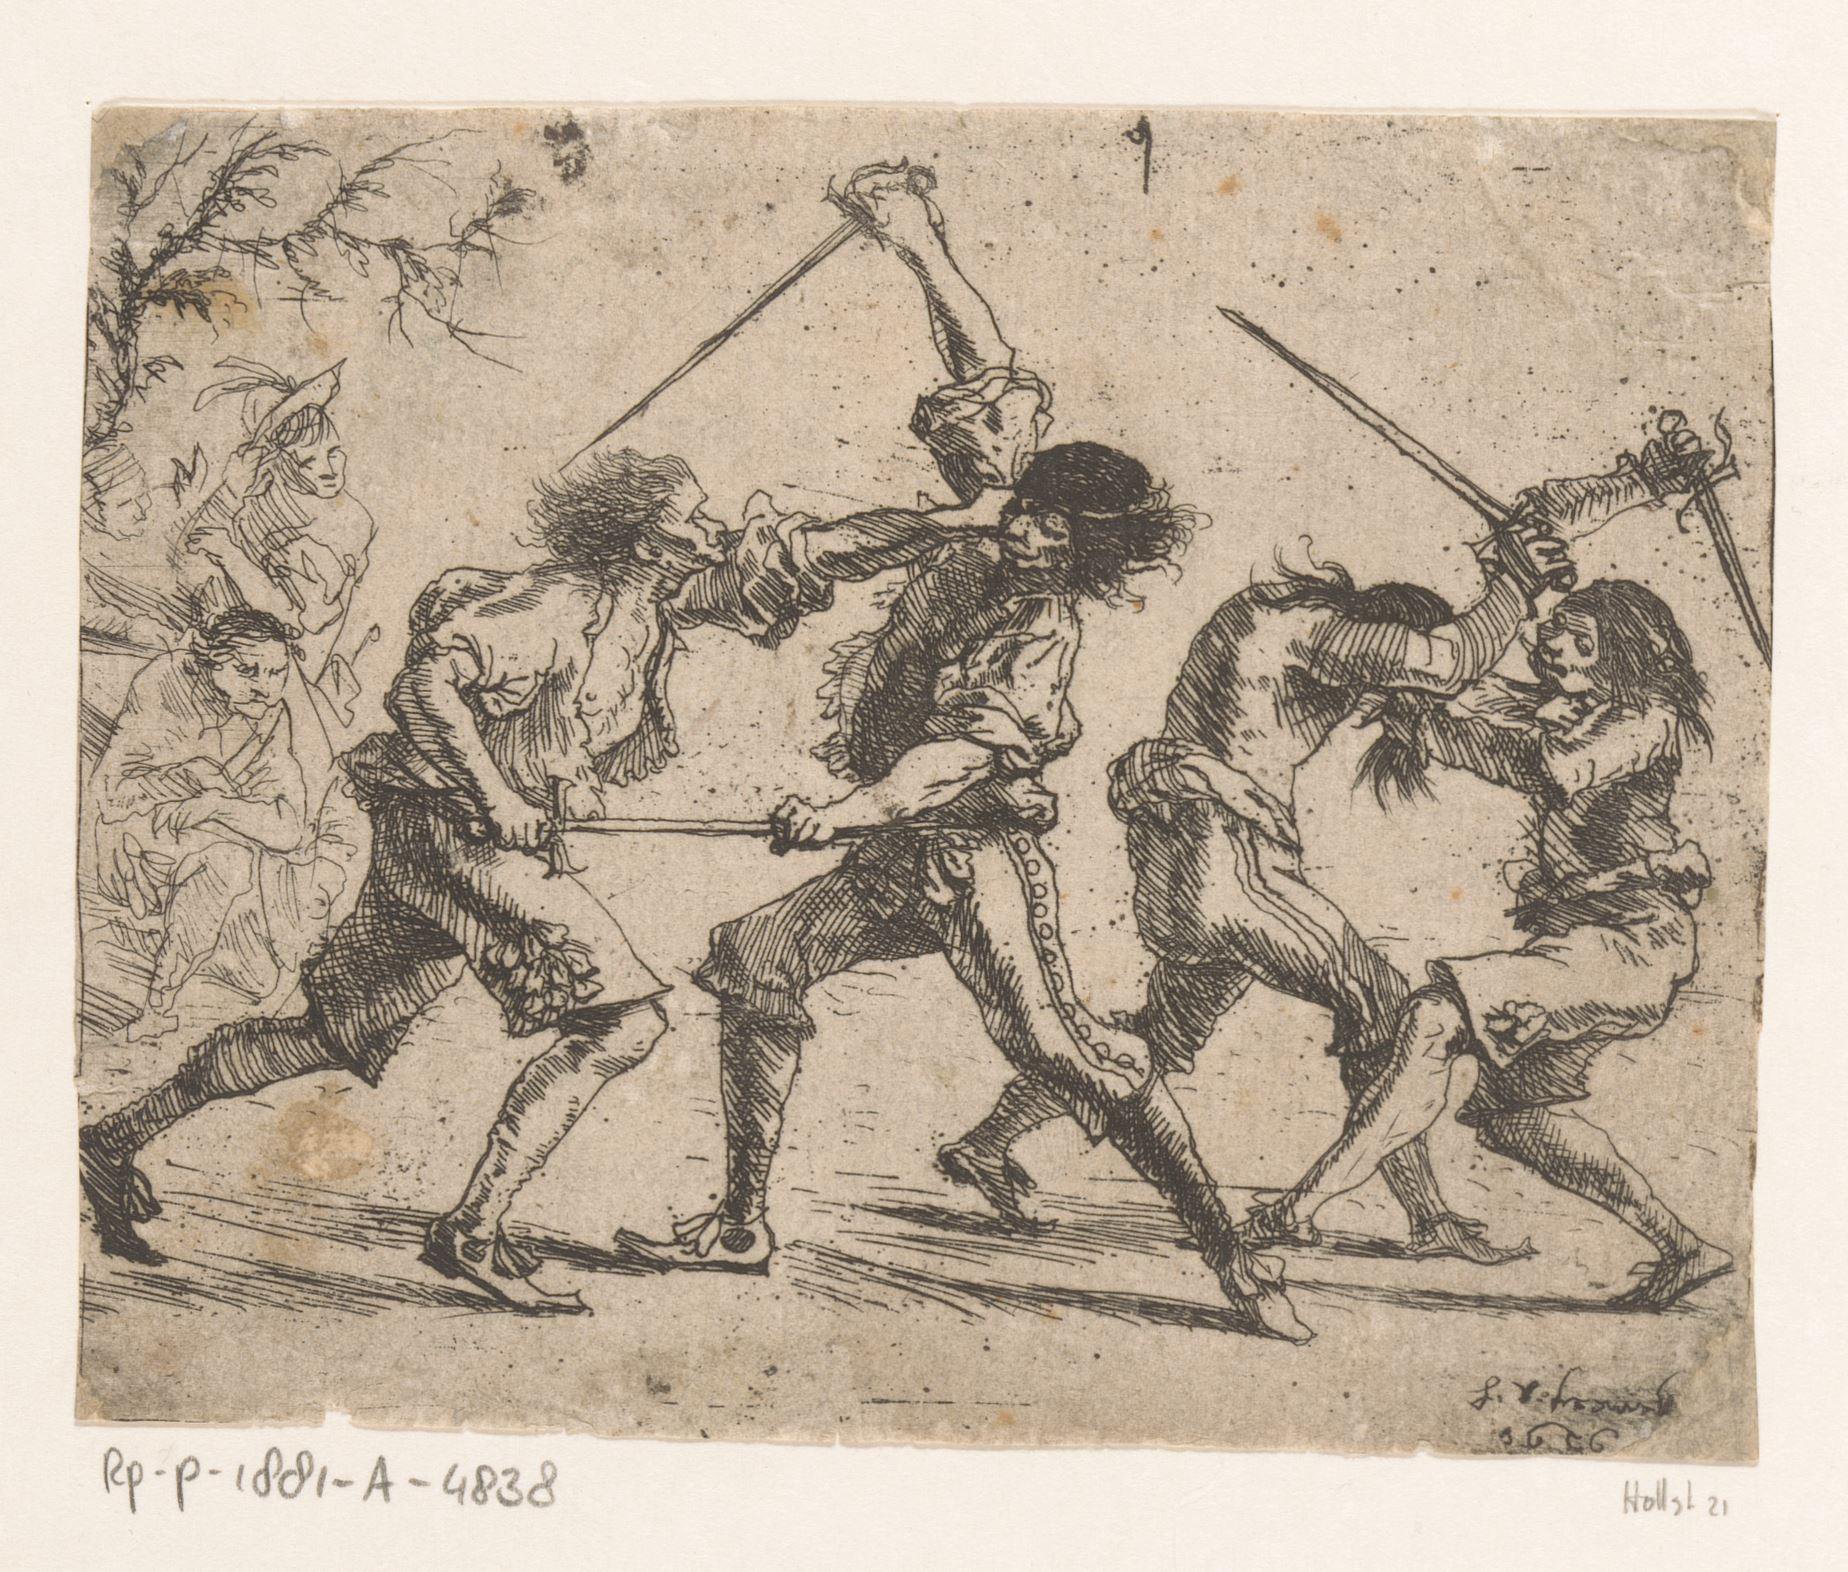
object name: print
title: Vier duellerende soldaten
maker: hans ulrich franck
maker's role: draughtsman, print maker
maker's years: 1603-1680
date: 1604-1656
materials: paper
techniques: etching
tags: duelling, hacking and thrusting weapons: rapier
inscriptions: collector's mark: Lugt 2228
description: Prent uit een serie van vijfentwintig militaire voorstellingen, waarvan tien in de collectie van het RMA aanwezig zijn.